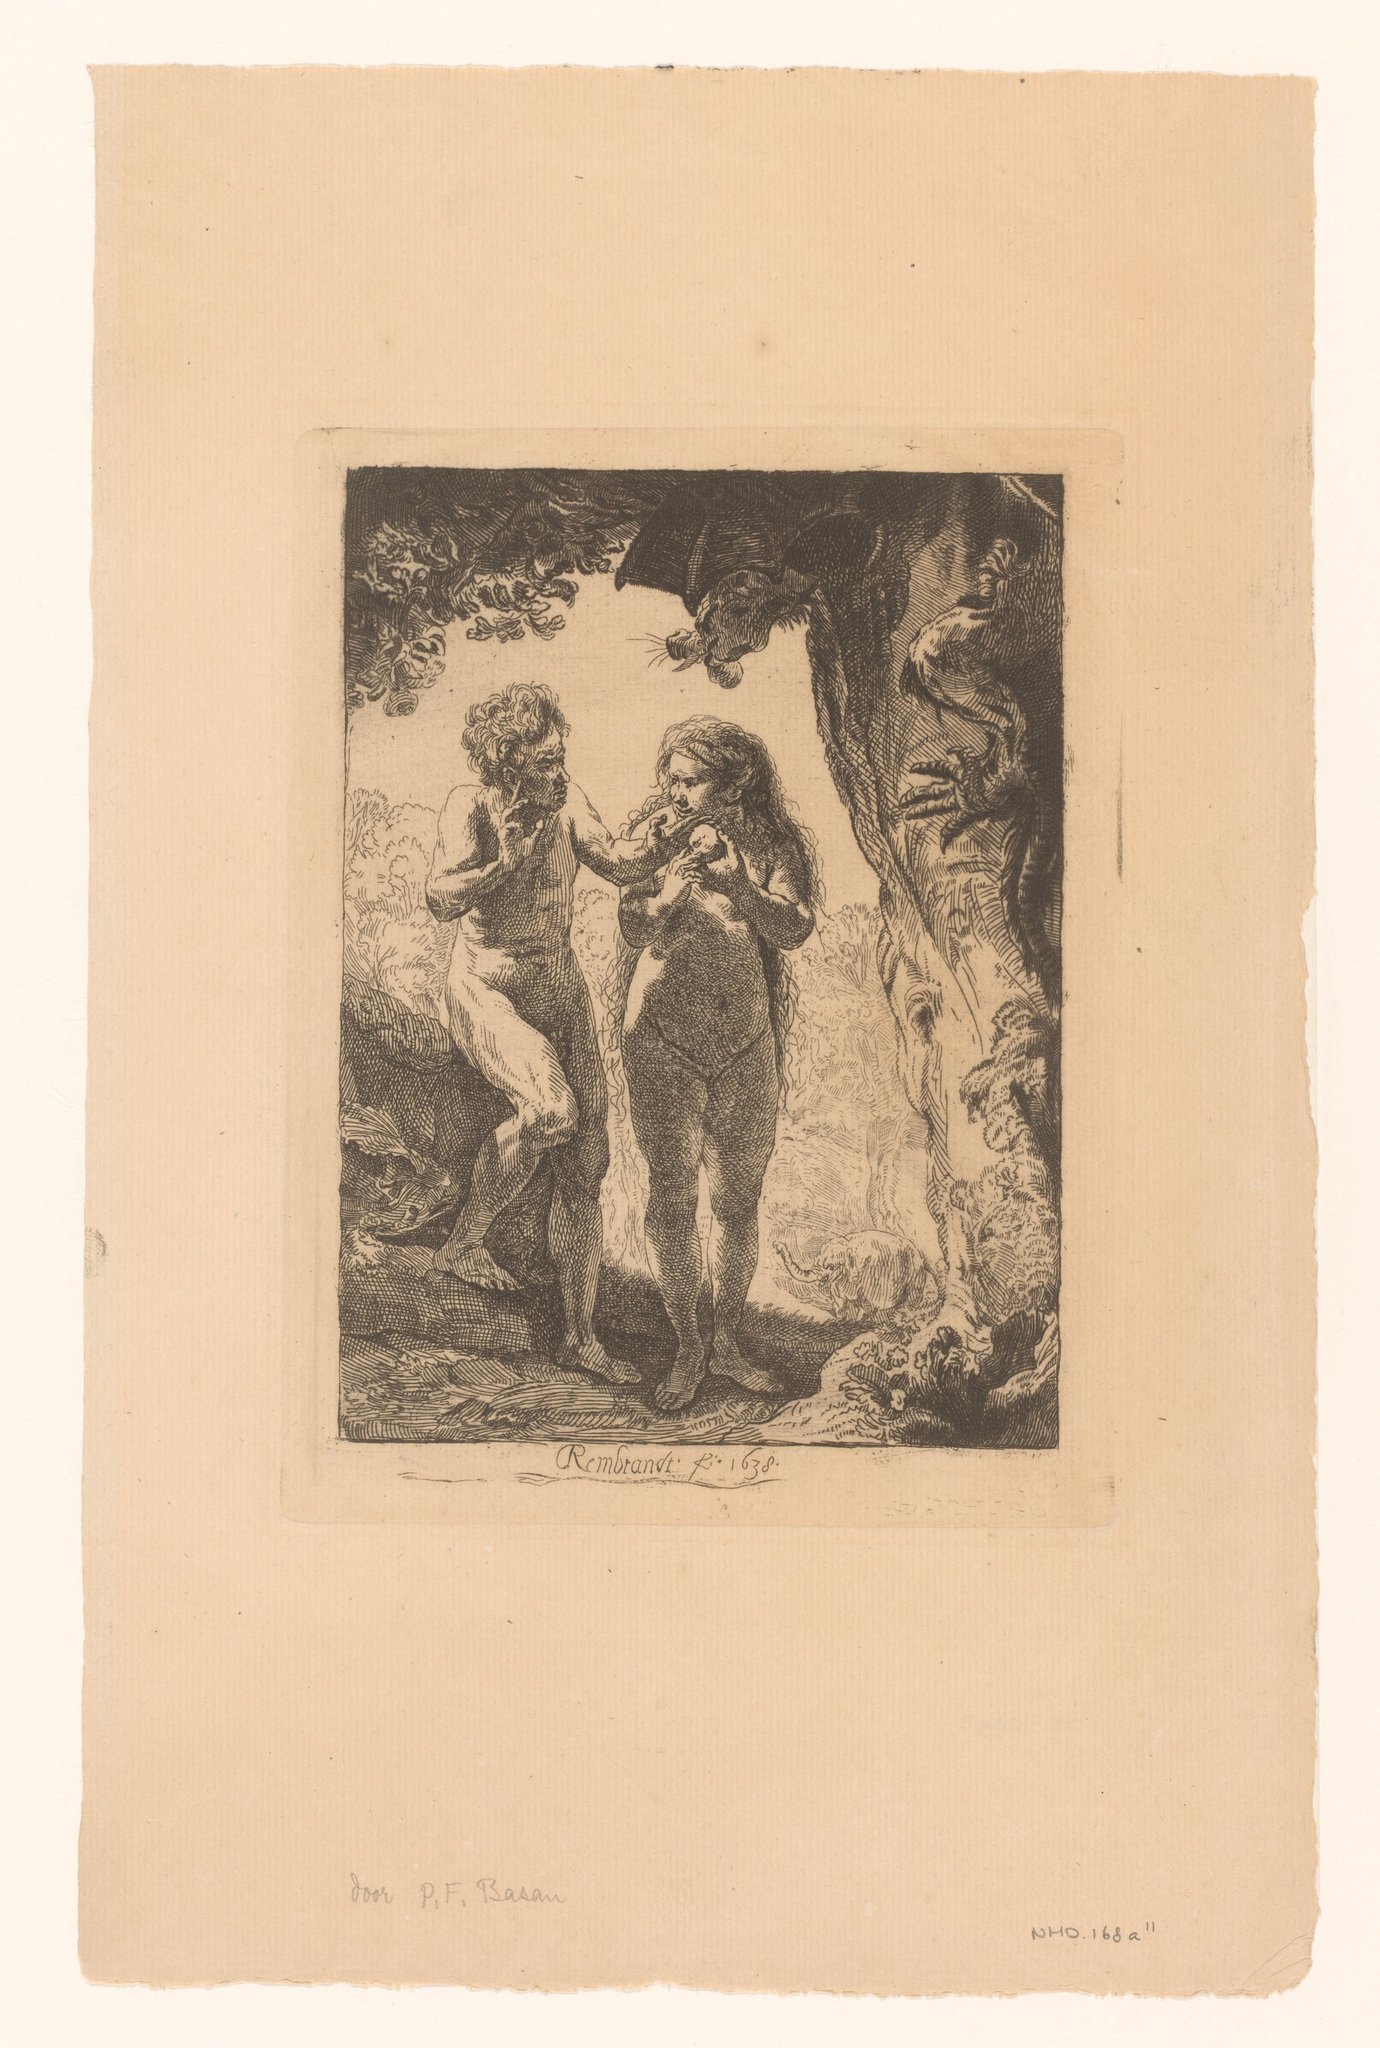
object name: print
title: Adam and Eve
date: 1733-1797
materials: paper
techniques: etching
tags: temptation and fall (genesis 3:1-7)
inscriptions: collector's mark: Lugt 2228